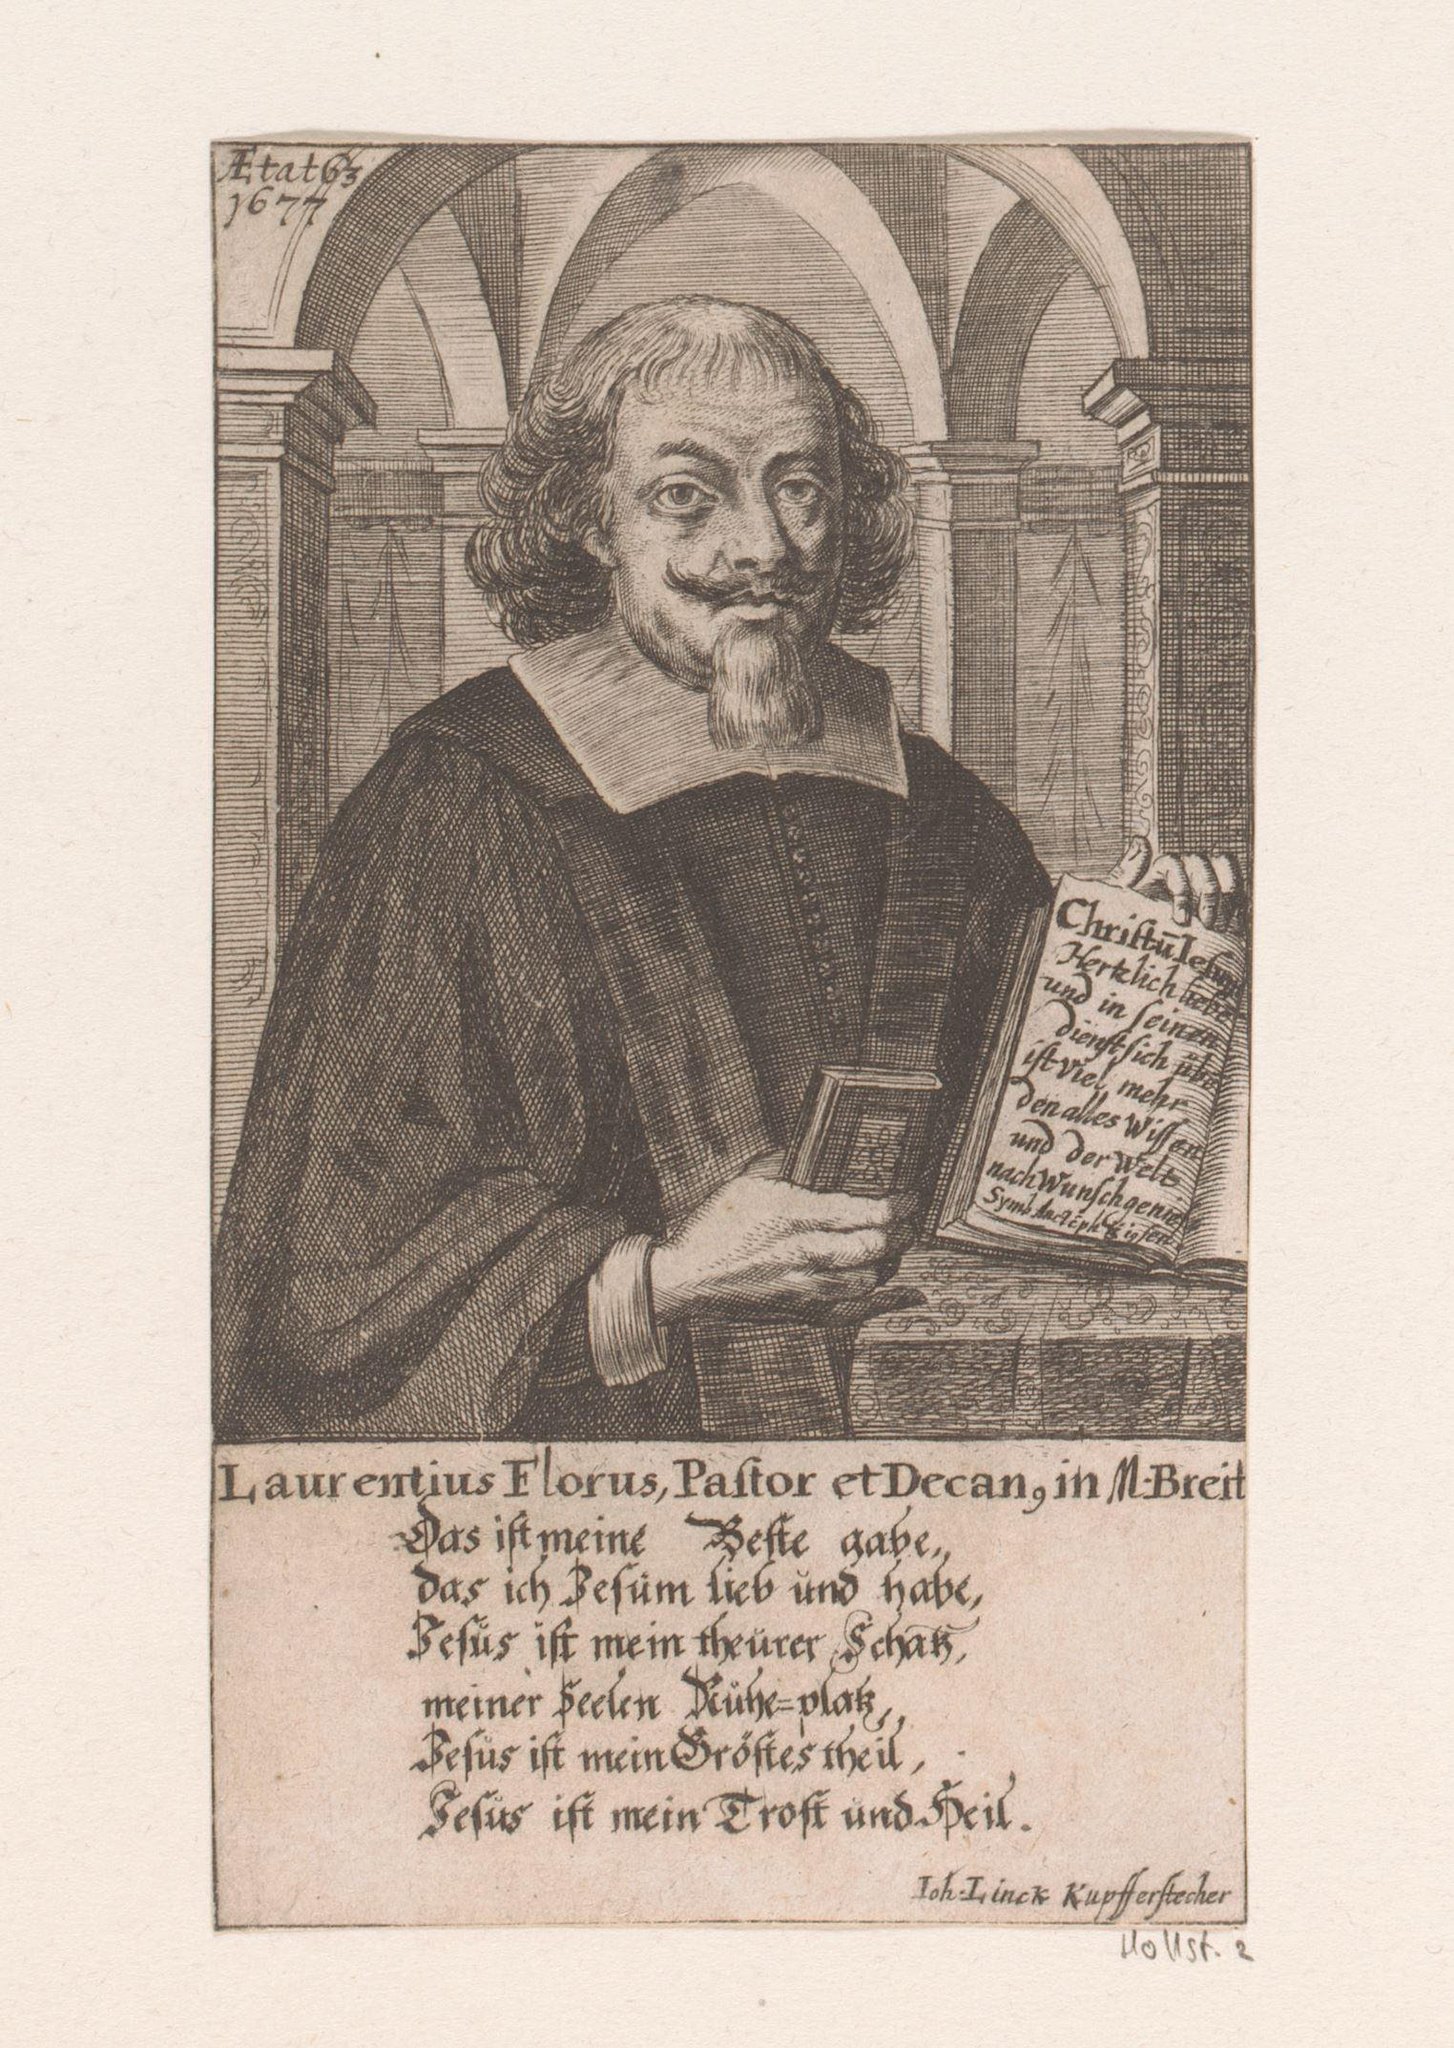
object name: print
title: Portret van Laurentius Florus op 63-jarige leeftijd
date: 1677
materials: paper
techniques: engraving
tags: theologian, historical persons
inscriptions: collector's mark: Lugt 2228